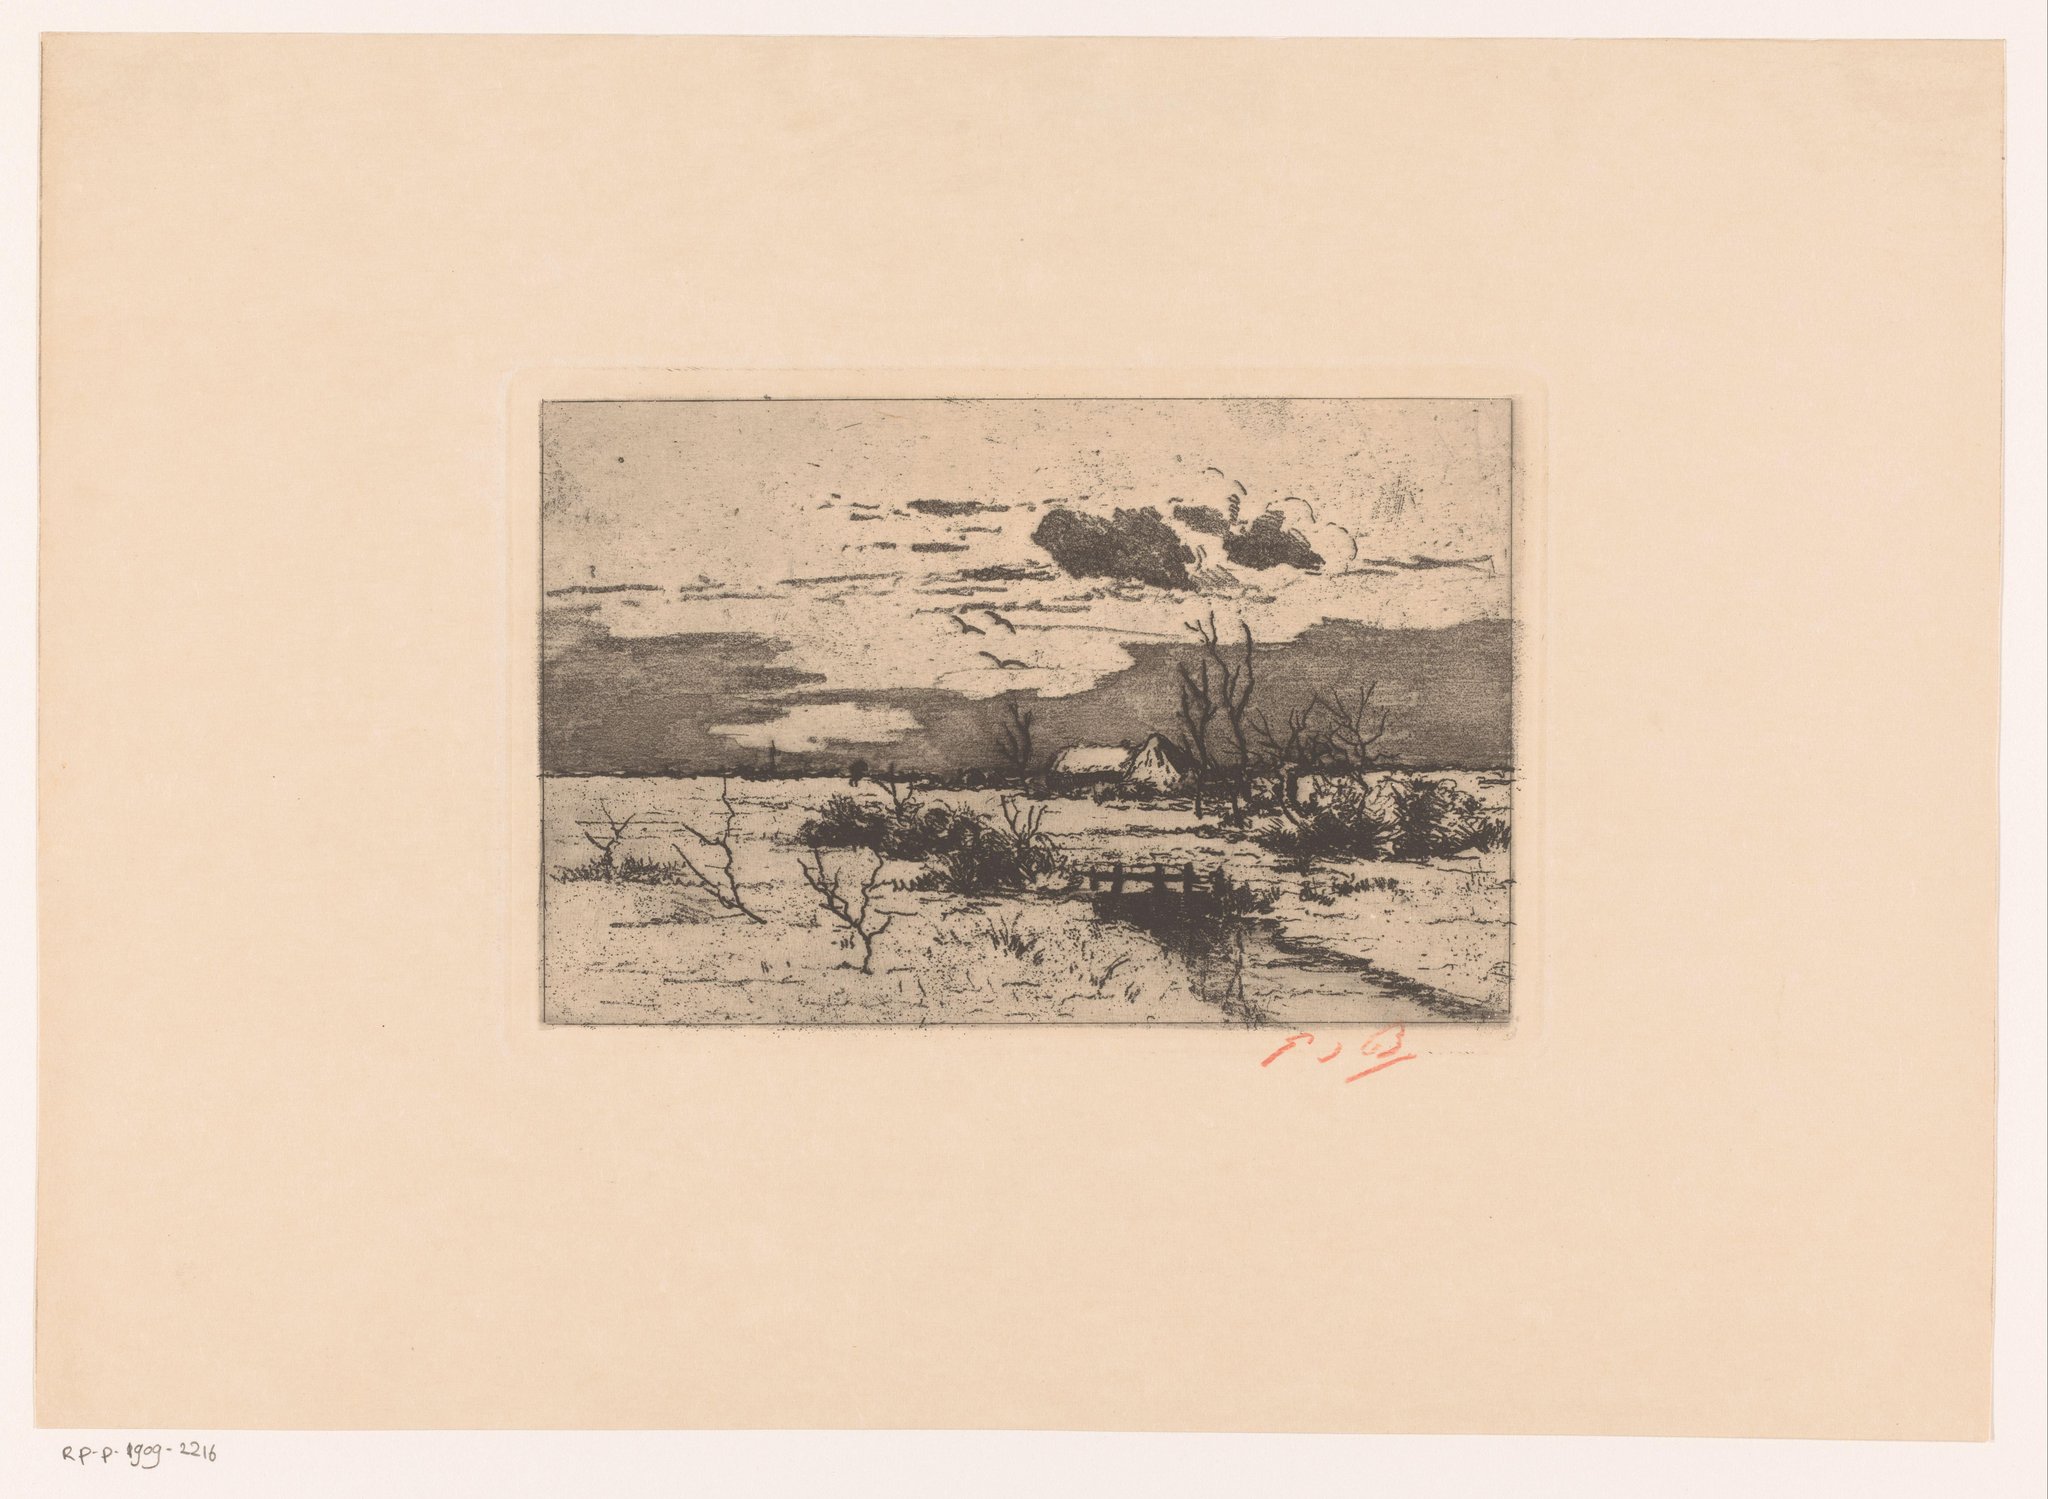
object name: print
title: Winterlandschap met boerderij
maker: emile de baré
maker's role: painter, print maker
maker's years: 1855-1902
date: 1865-1902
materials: paper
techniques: drypoint, etching, intaglio, soft ground etching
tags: landscapes, farm or solitary house in landscape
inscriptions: collector's mark: Lugt 2228